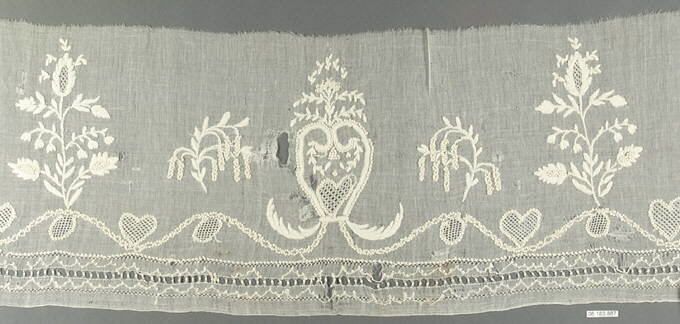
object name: fragment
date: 1801-1900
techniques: embroidery